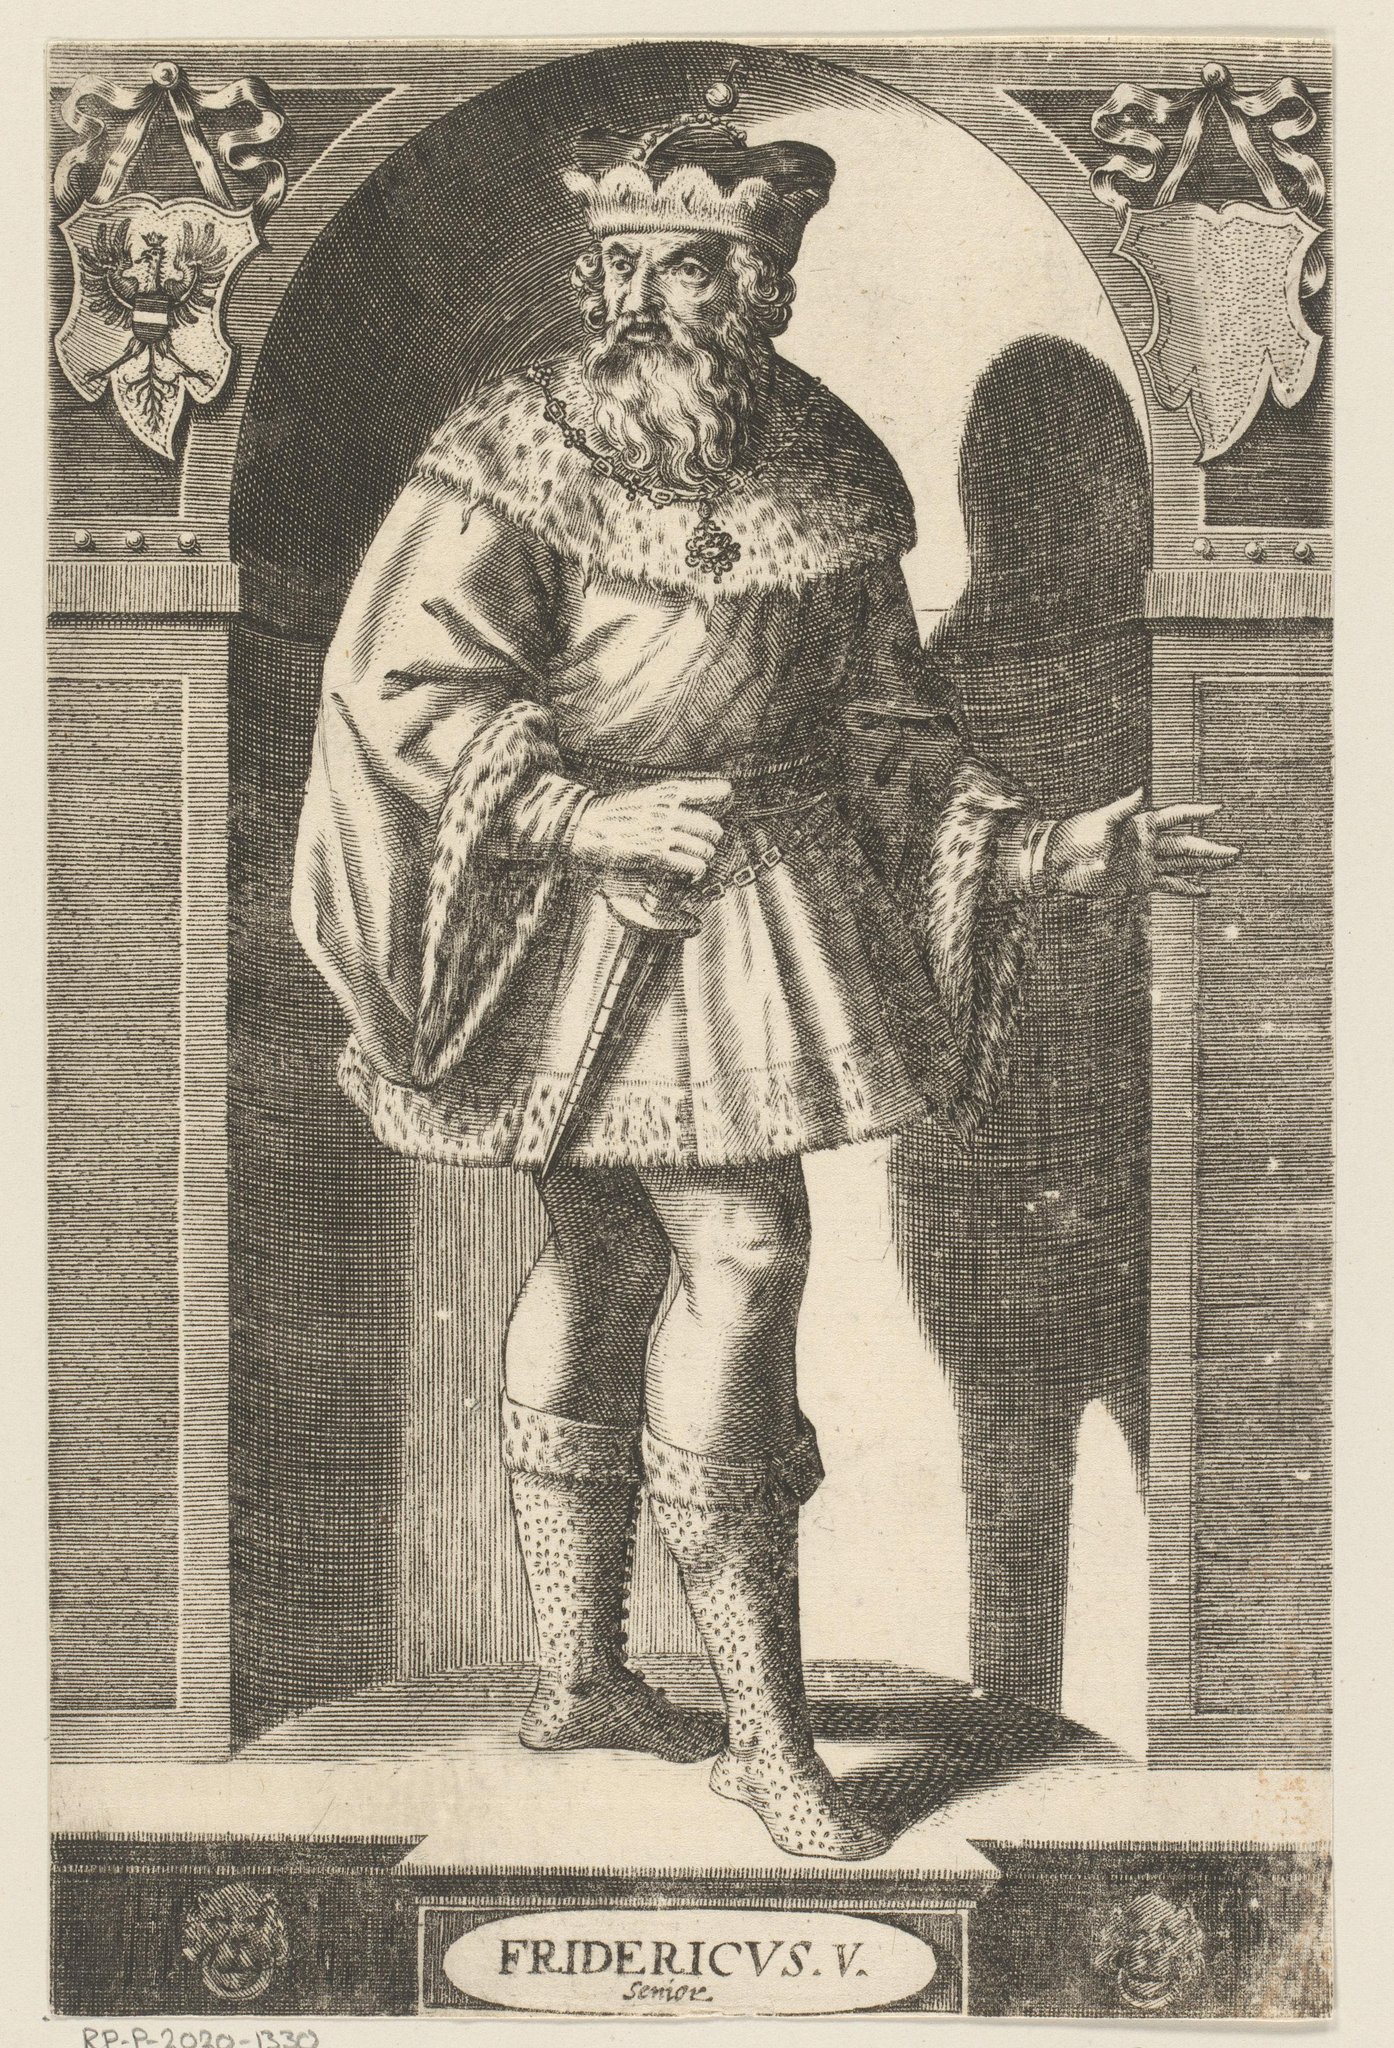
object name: print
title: Fridericus V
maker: dominicus custos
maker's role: print maker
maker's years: 1560-1615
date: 1599-1623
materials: paper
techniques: engraving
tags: historical persons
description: Prent waarschijnlijk voor het eerst verschenen in: Henning, Marcus. Tirolensium Principum Comitum. Augsburg: Johannes Praetorius, 1599. Prent ook gebruikt in latere publicaties, in ieder geval tot in 1623.